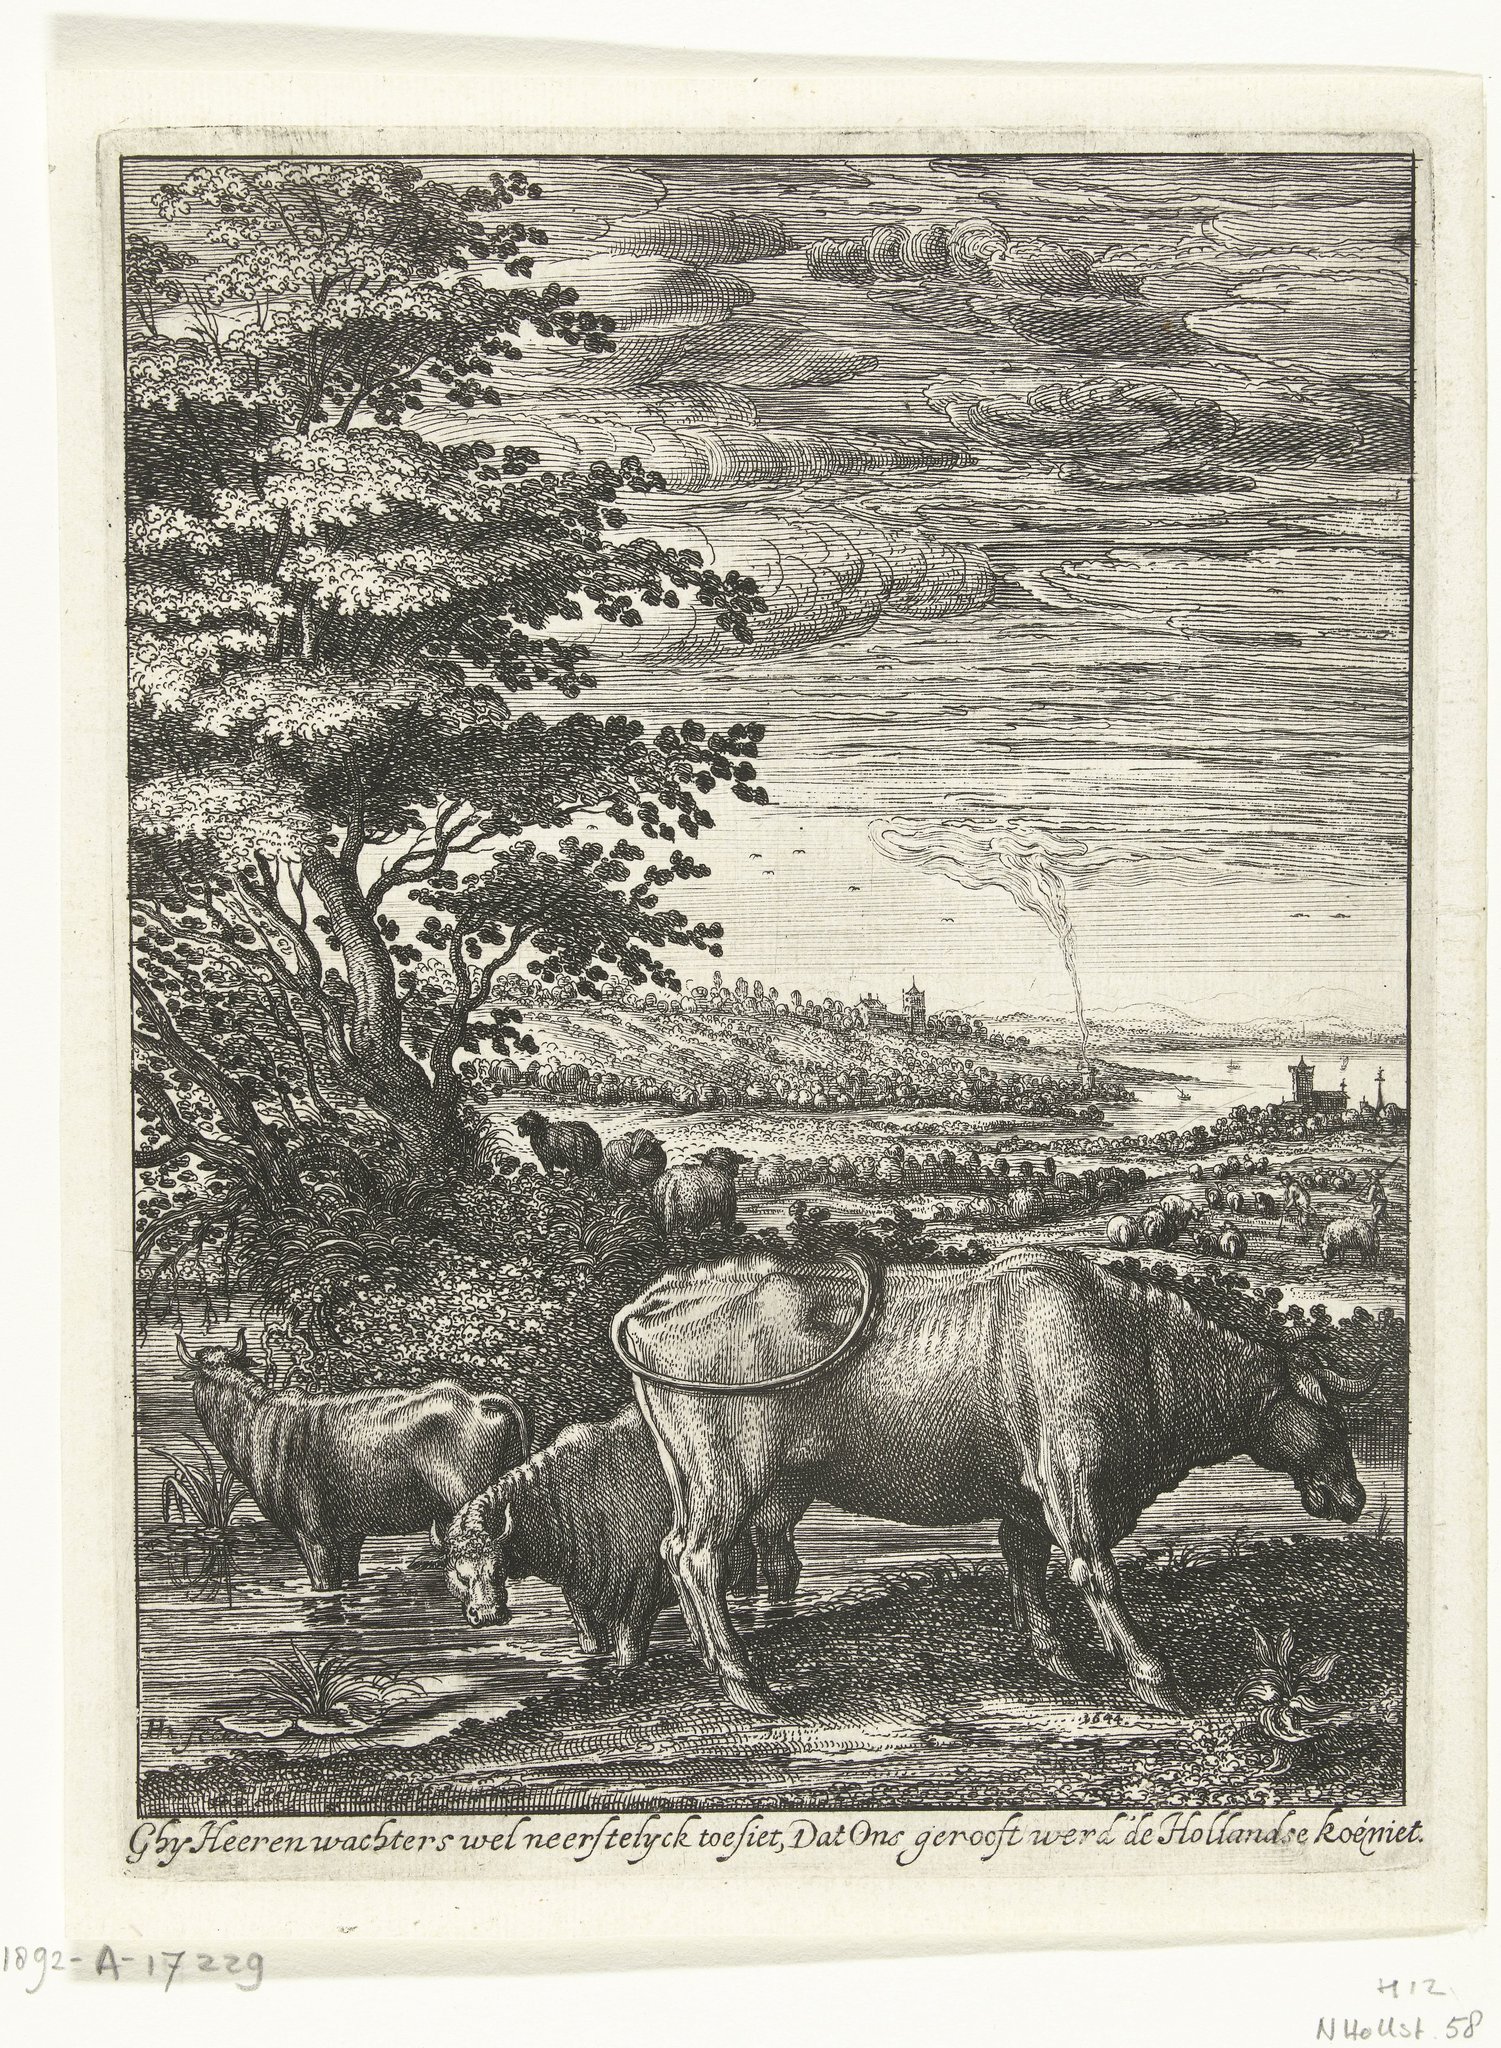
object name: print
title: Allegorische landschappen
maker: hendrick hondius (i)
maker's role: draughtsman, print maker, publisher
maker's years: 1573-1650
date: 1644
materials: paper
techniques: engraving, etching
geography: the hague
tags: cow, political caricatures and satires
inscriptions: collector's mark: Lugt 2228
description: Een weids rivierlandschap met op de voorgrond koeien en op de achtergrond schapen. Onder de voorstelling een regel in het Nederlands. Allegorie op de sociaal-economische situatie in de Nederlanden in 1644. Prent uit een serie van vijf allegorische landschappen met spreuken.